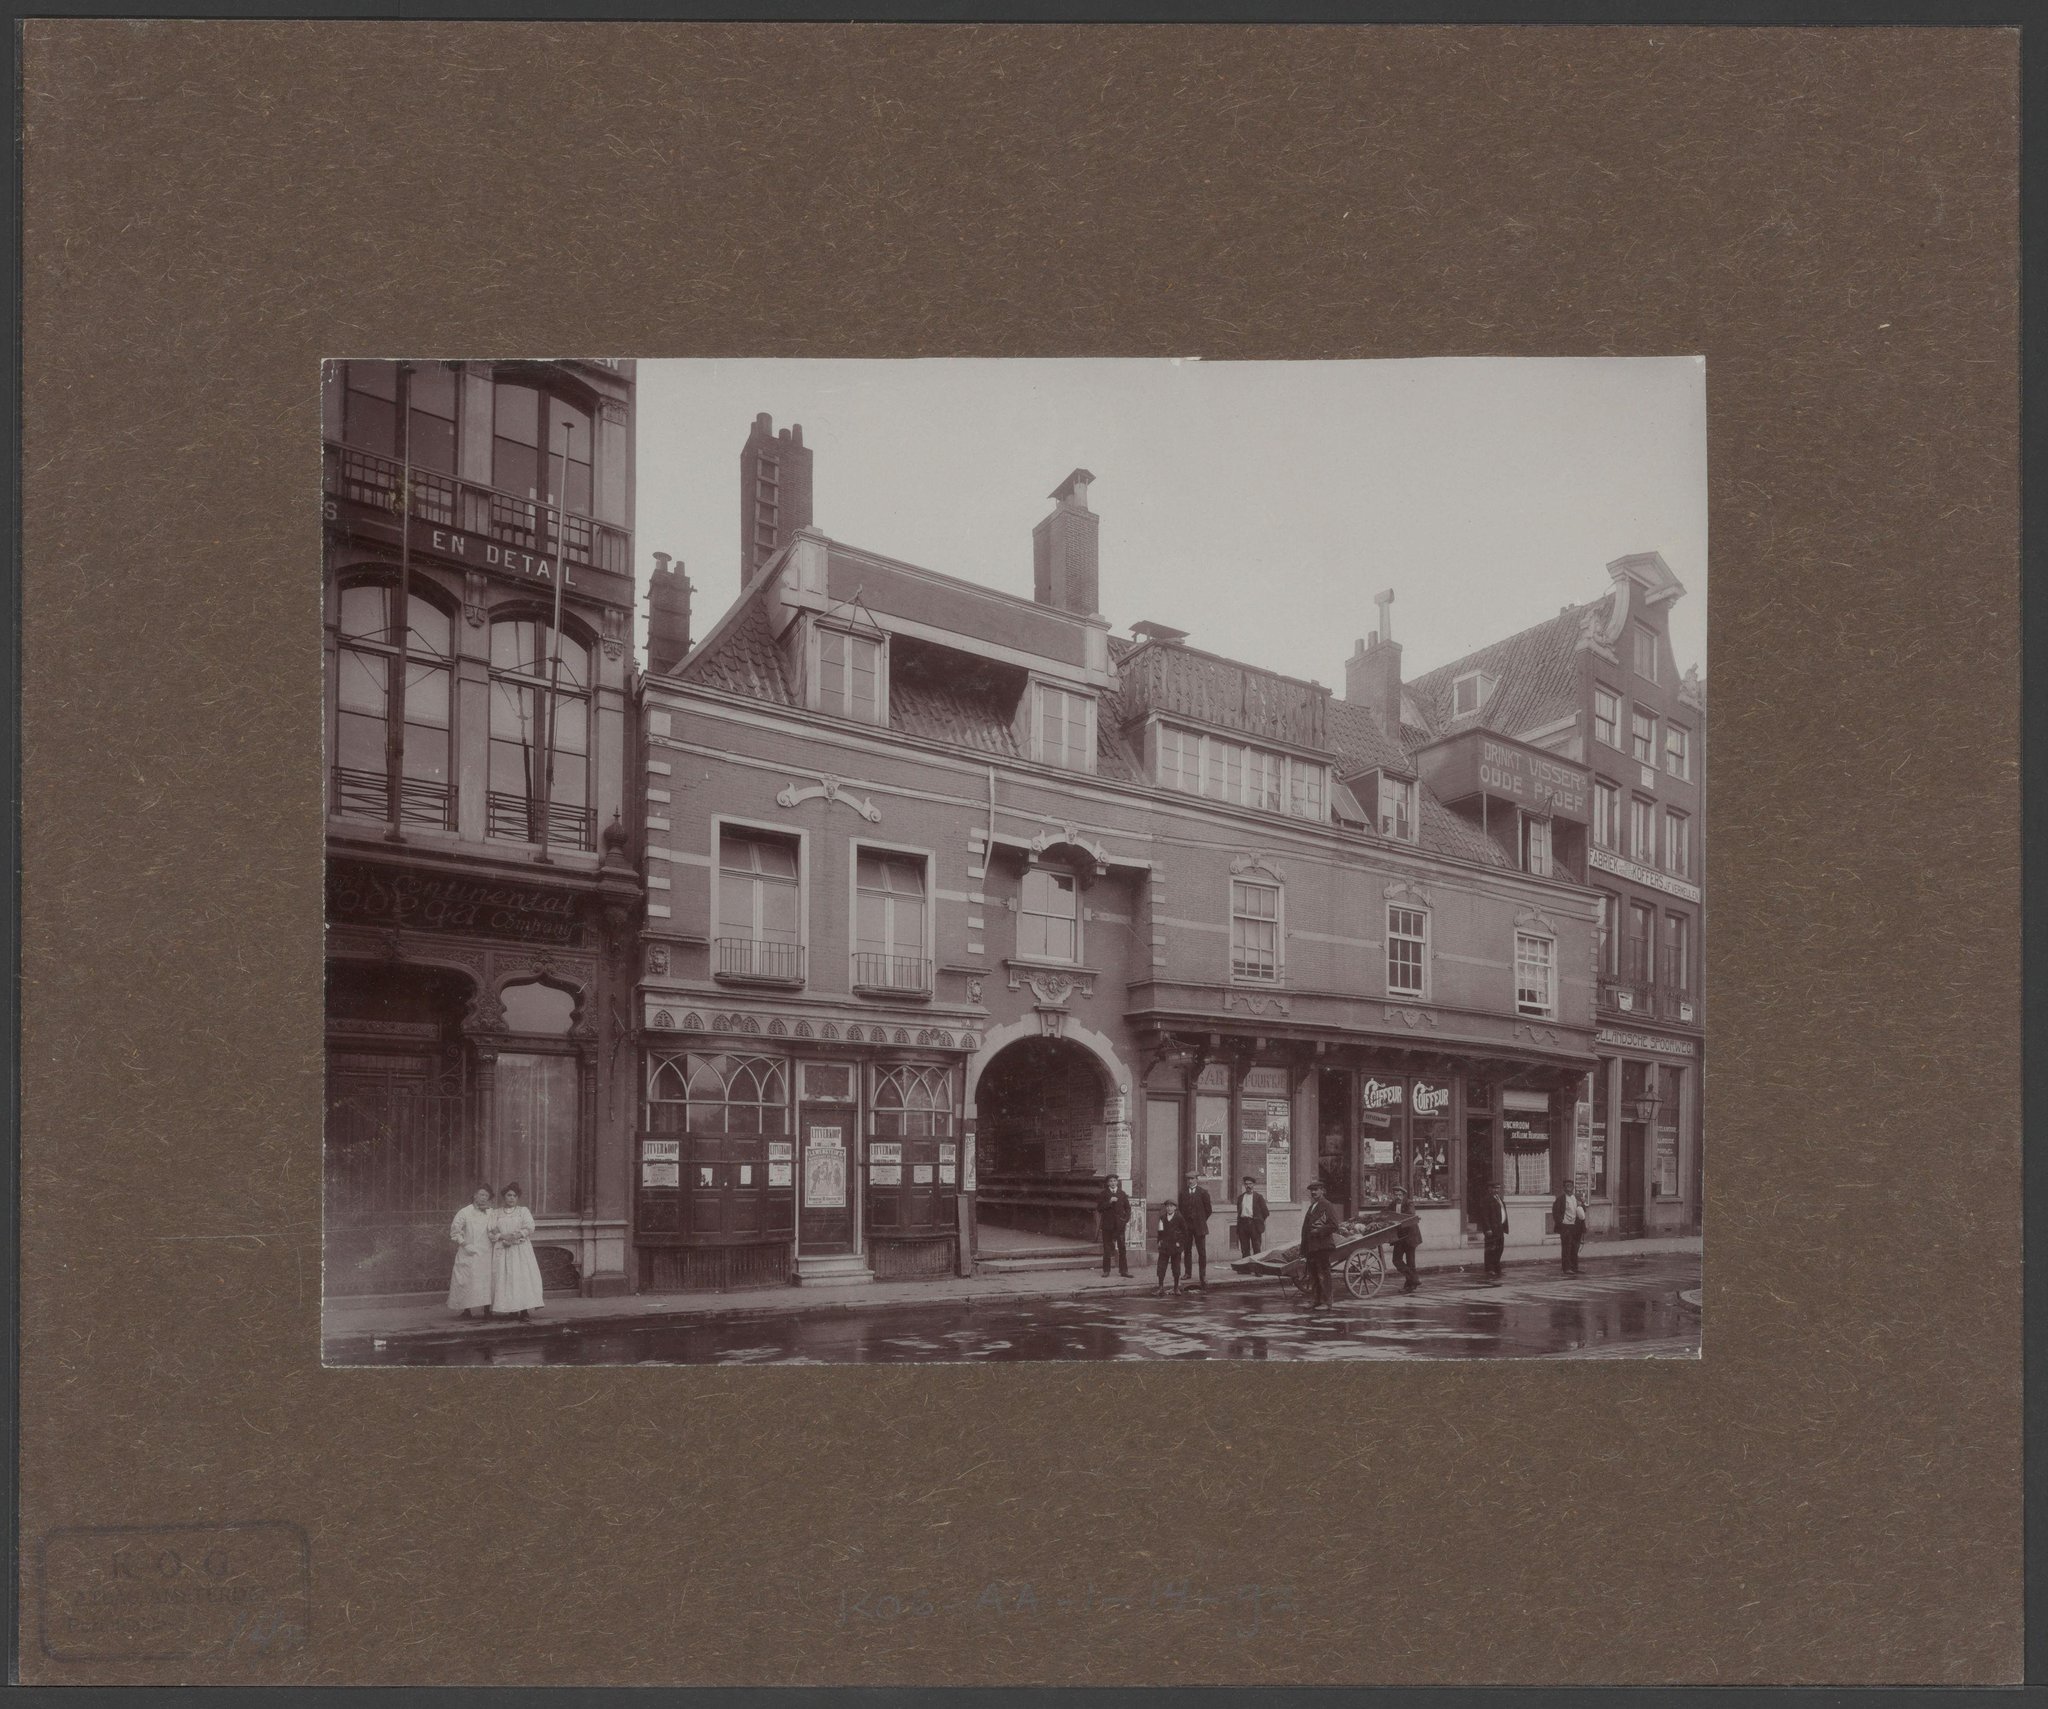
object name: photograph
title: Gezicht op de Vijgendam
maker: Anonymous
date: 1865-1950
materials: paper, cardboard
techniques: collodion silver print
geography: amsterdam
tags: city-view in general; 'veduta', the usual house or row of houses, street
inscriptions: collector's mark: ‘14.92’ Lugt 1641b, inscription: ‘Vijgendam’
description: Onderwerpsrubriek binnen de Atlas Amsterdam: Voorburgwal (O.Z.), Voorweg, Vijgendam, Vijzelstraat.